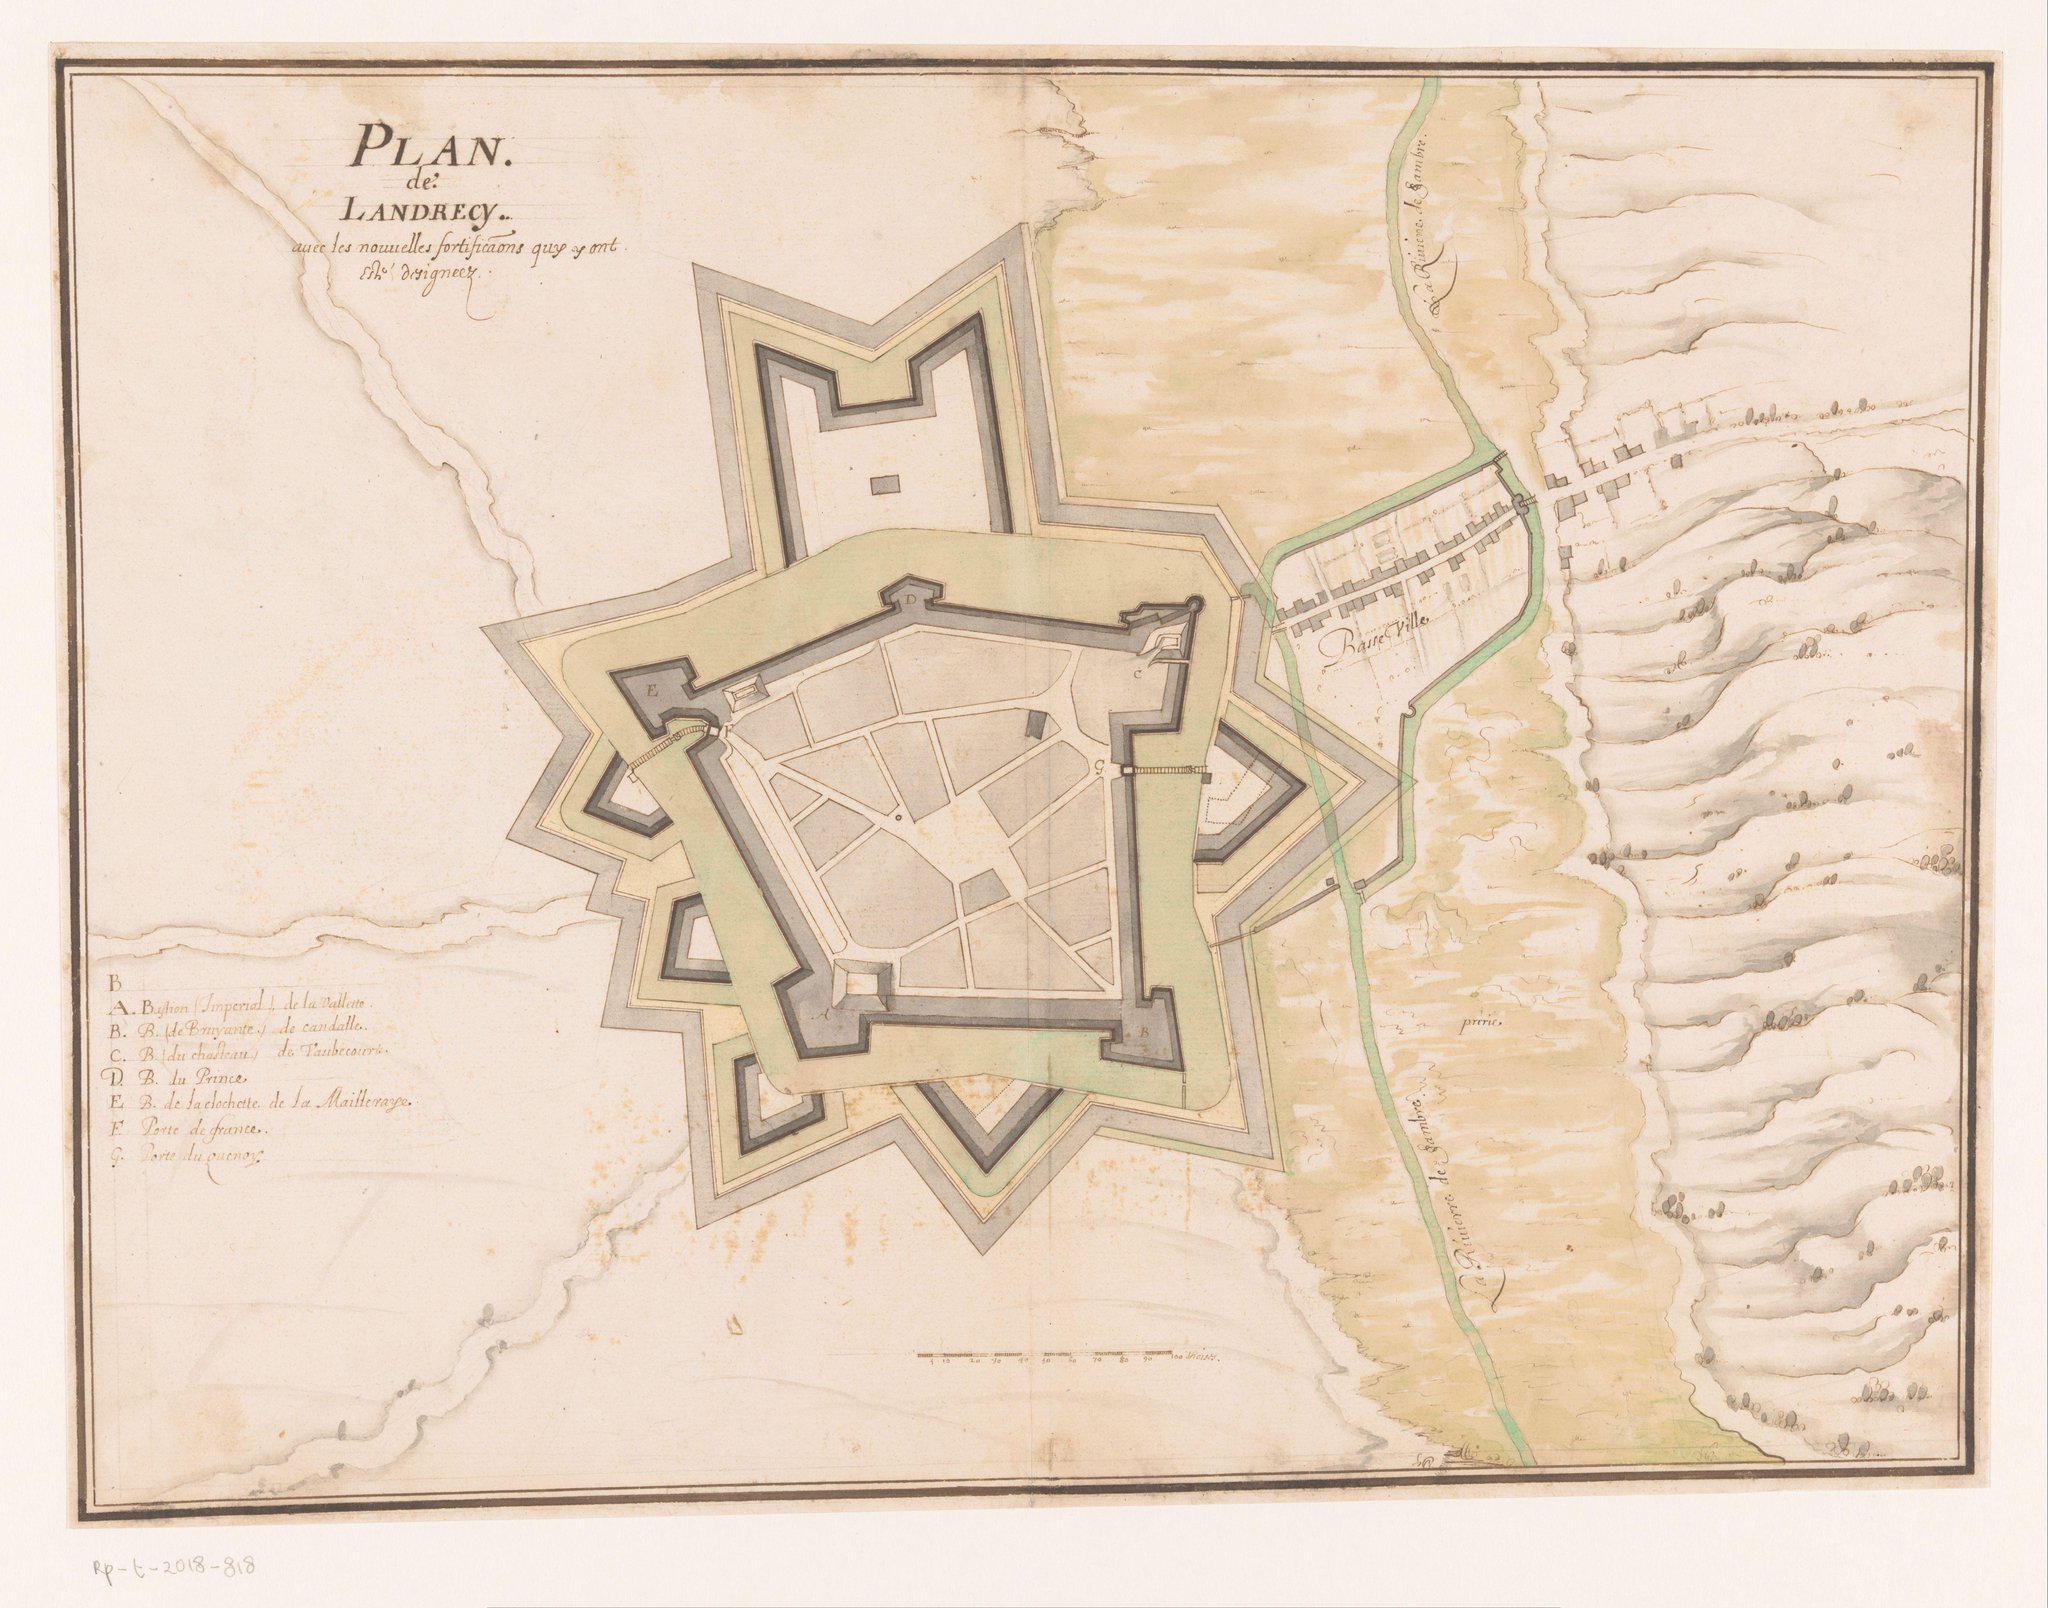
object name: drawing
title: Vestingplattegrond van Landeschie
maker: Anonymous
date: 1650-1700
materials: ink, paper, pencil, watercolor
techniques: brush, pen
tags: fortified city, maps of cities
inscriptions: collector's mark: Lugt 2228